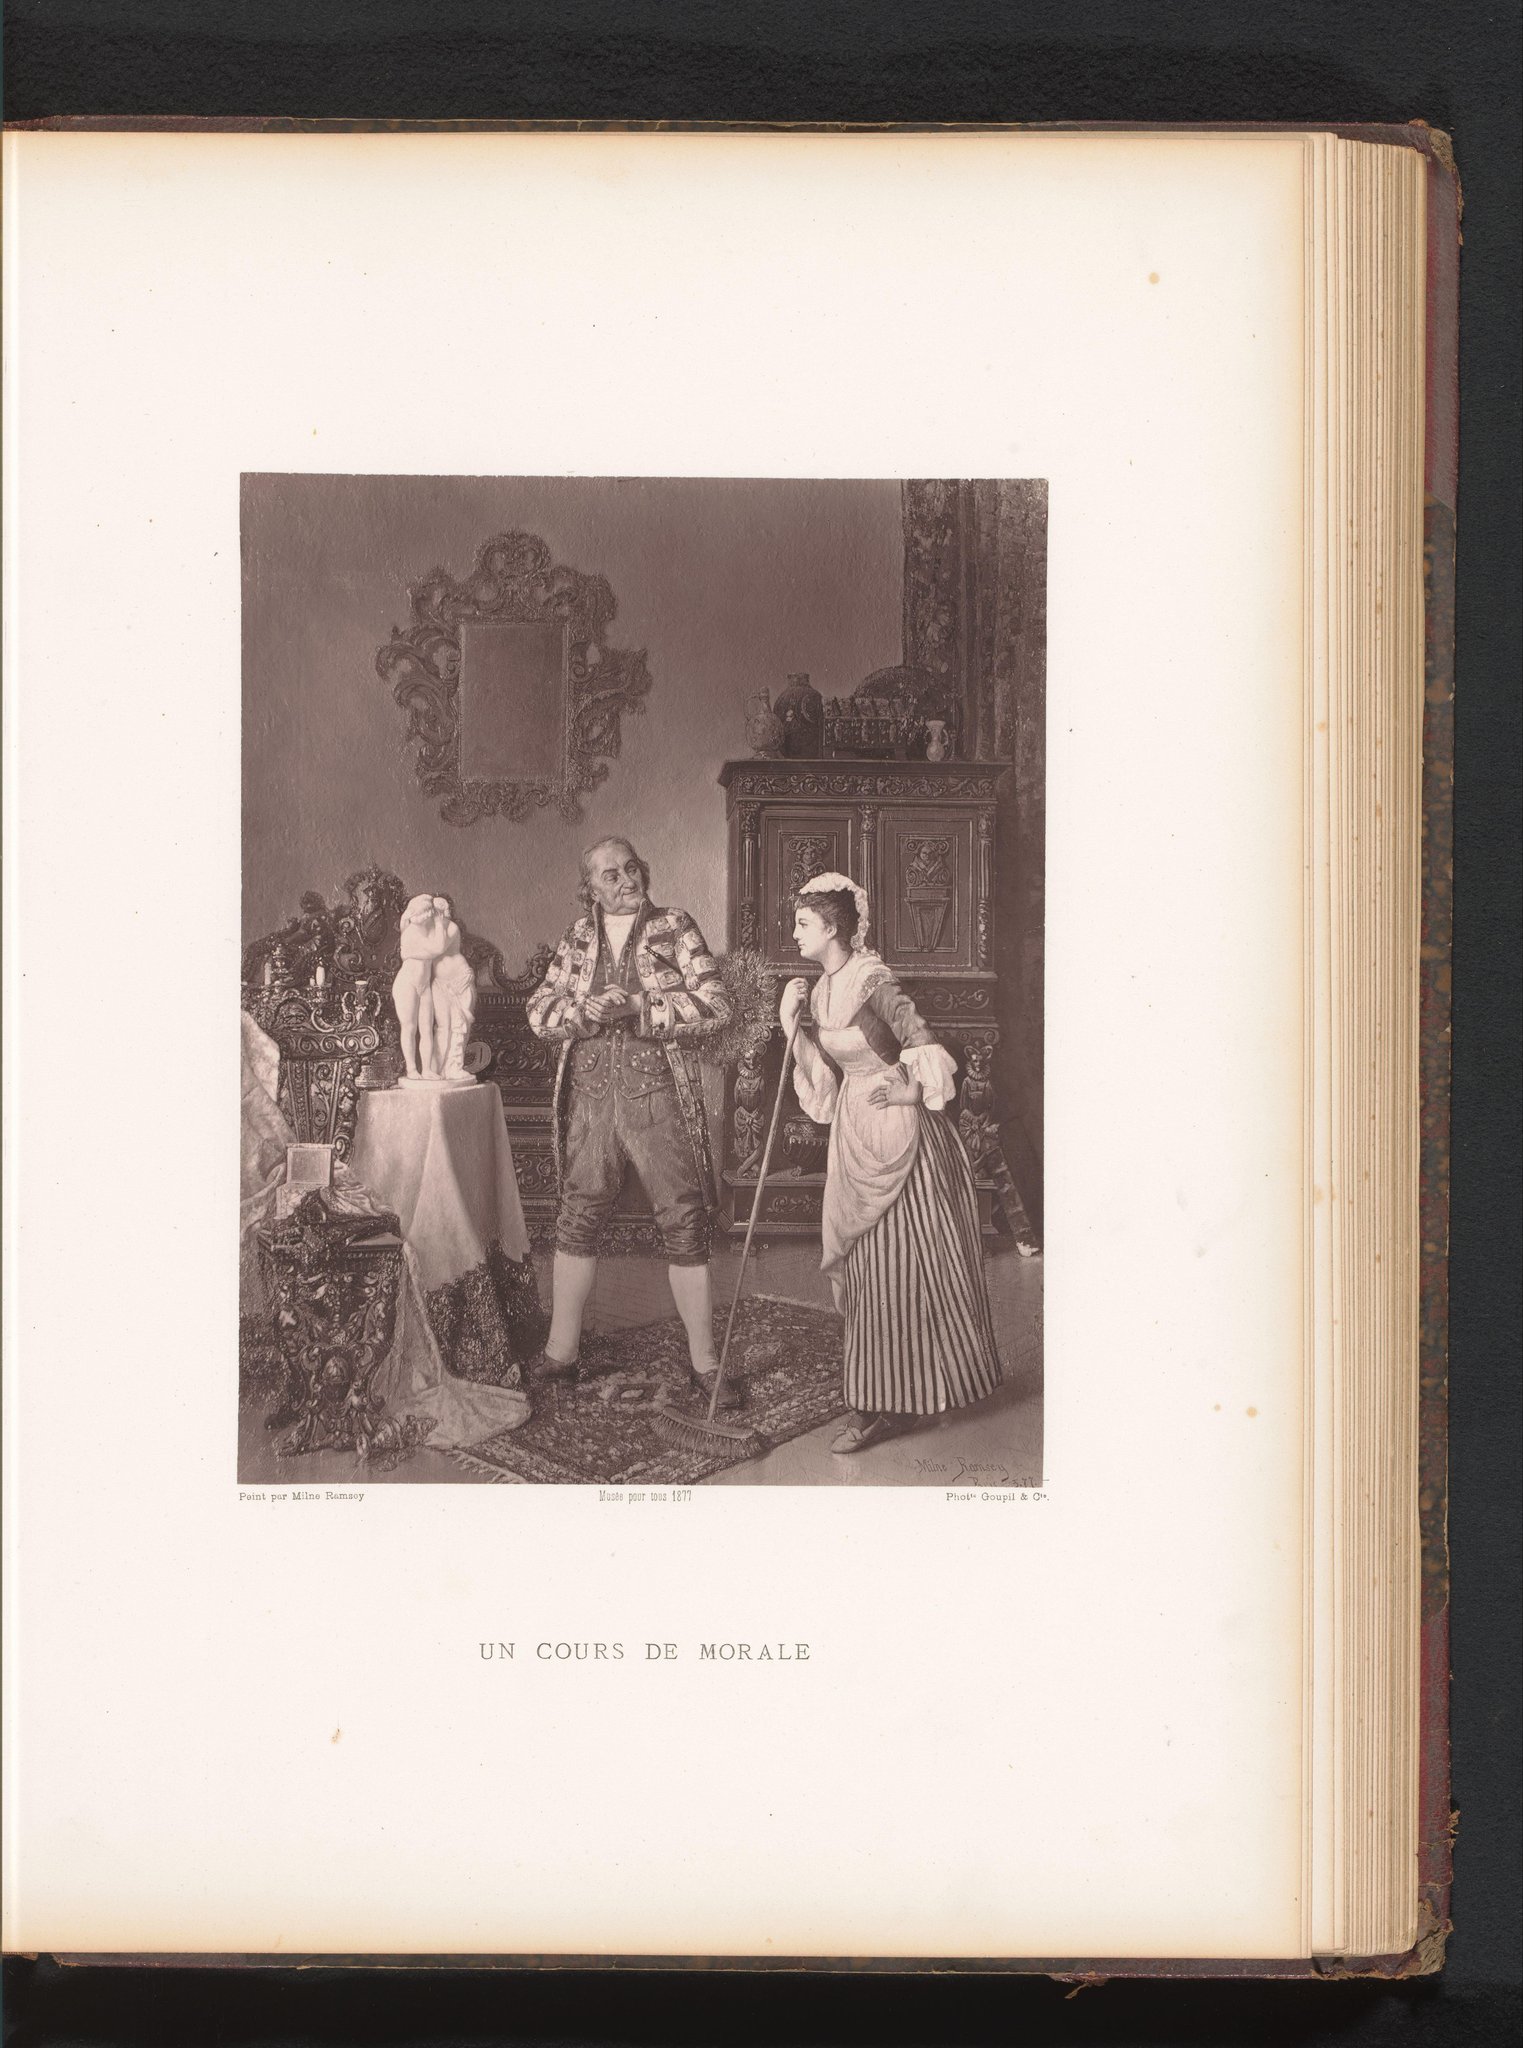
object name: photomechanical print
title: Reproductie van een schilderij van een man en vrouw binnenshuis door Milne Ramsey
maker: milne ramsey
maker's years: 1847-1915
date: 1872-1879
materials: paper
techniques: woodburytype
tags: man and woman cohabiting, communal rooms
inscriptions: inscription: ‘Musée pour tous 1877’